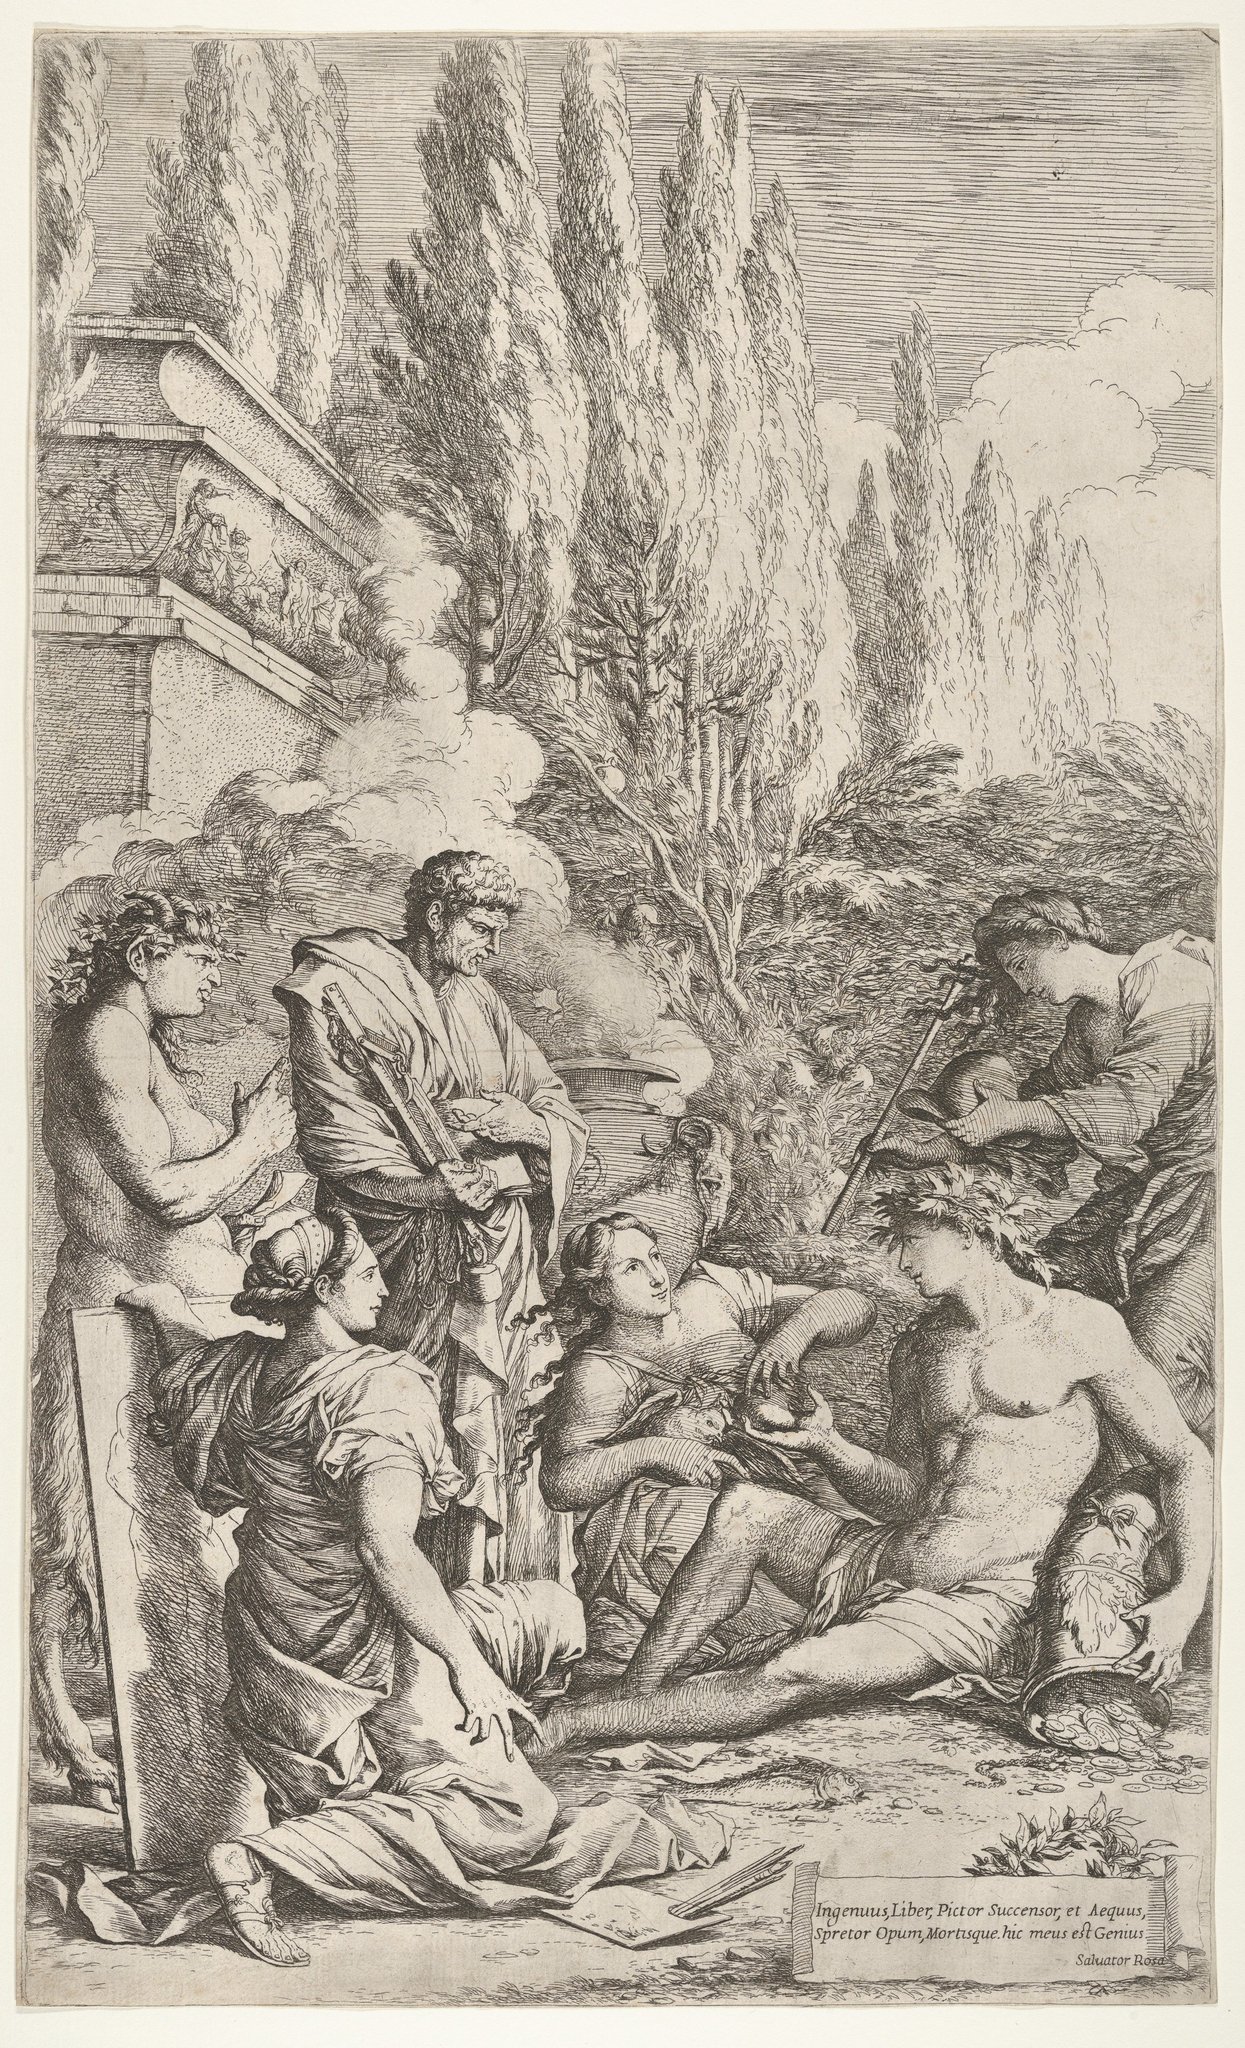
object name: print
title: The Genius of Salvator Rosa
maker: salvator rosa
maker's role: artist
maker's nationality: italian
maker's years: 1615-1673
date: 1662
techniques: drypoint, etching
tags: men,women,trees